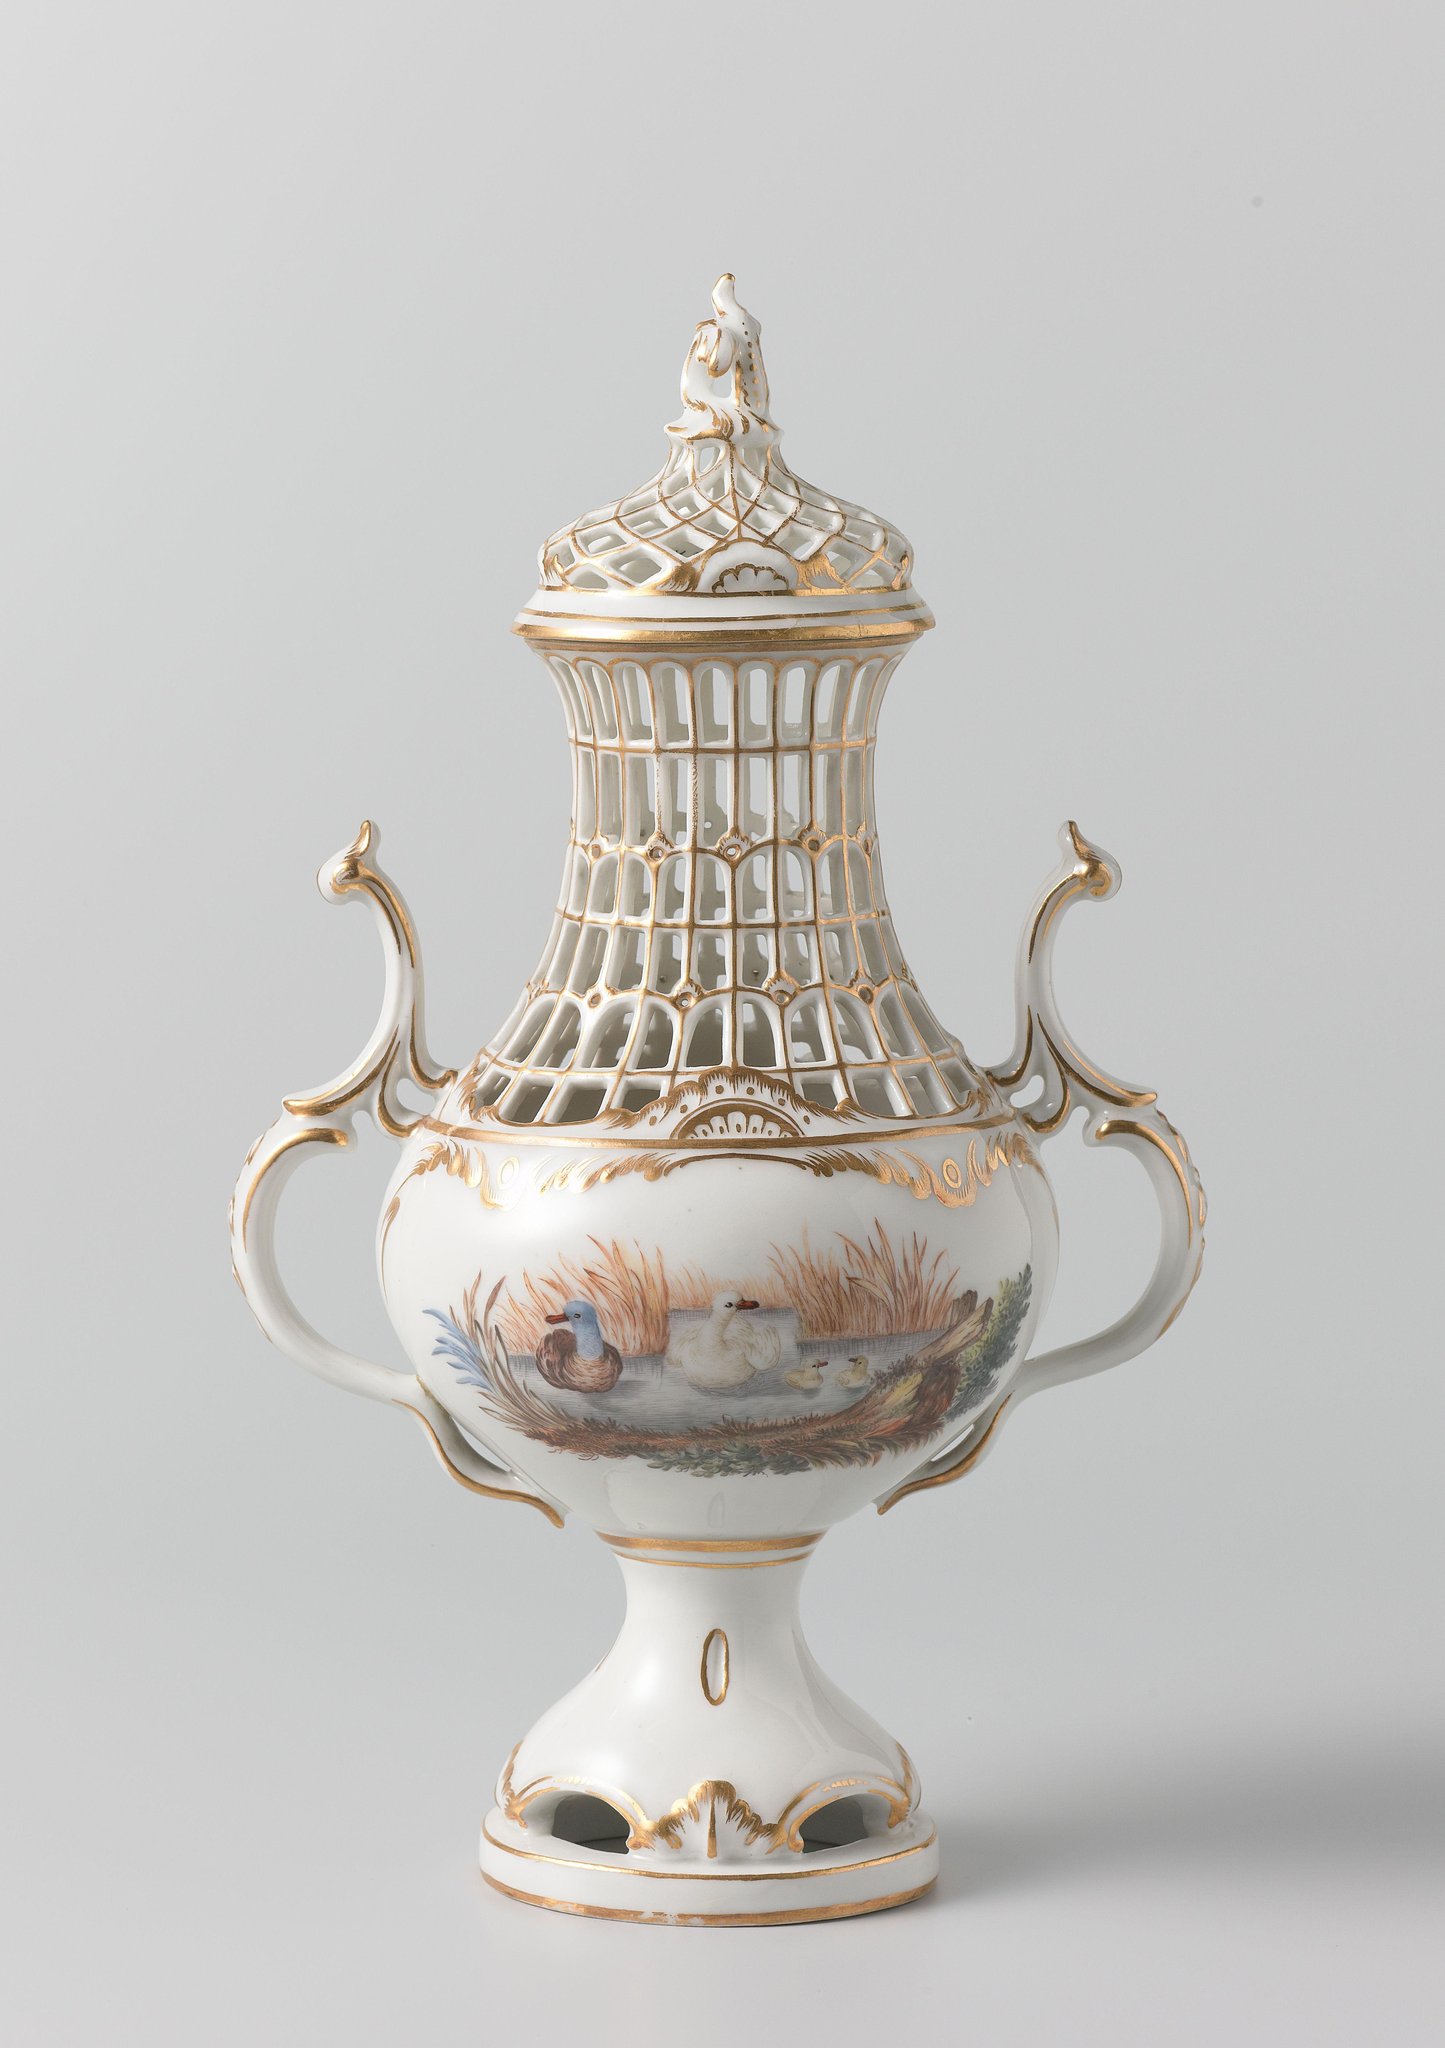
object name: vase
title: Group of vases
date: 1784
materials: porcelain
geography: ouderkerk aan de amstel